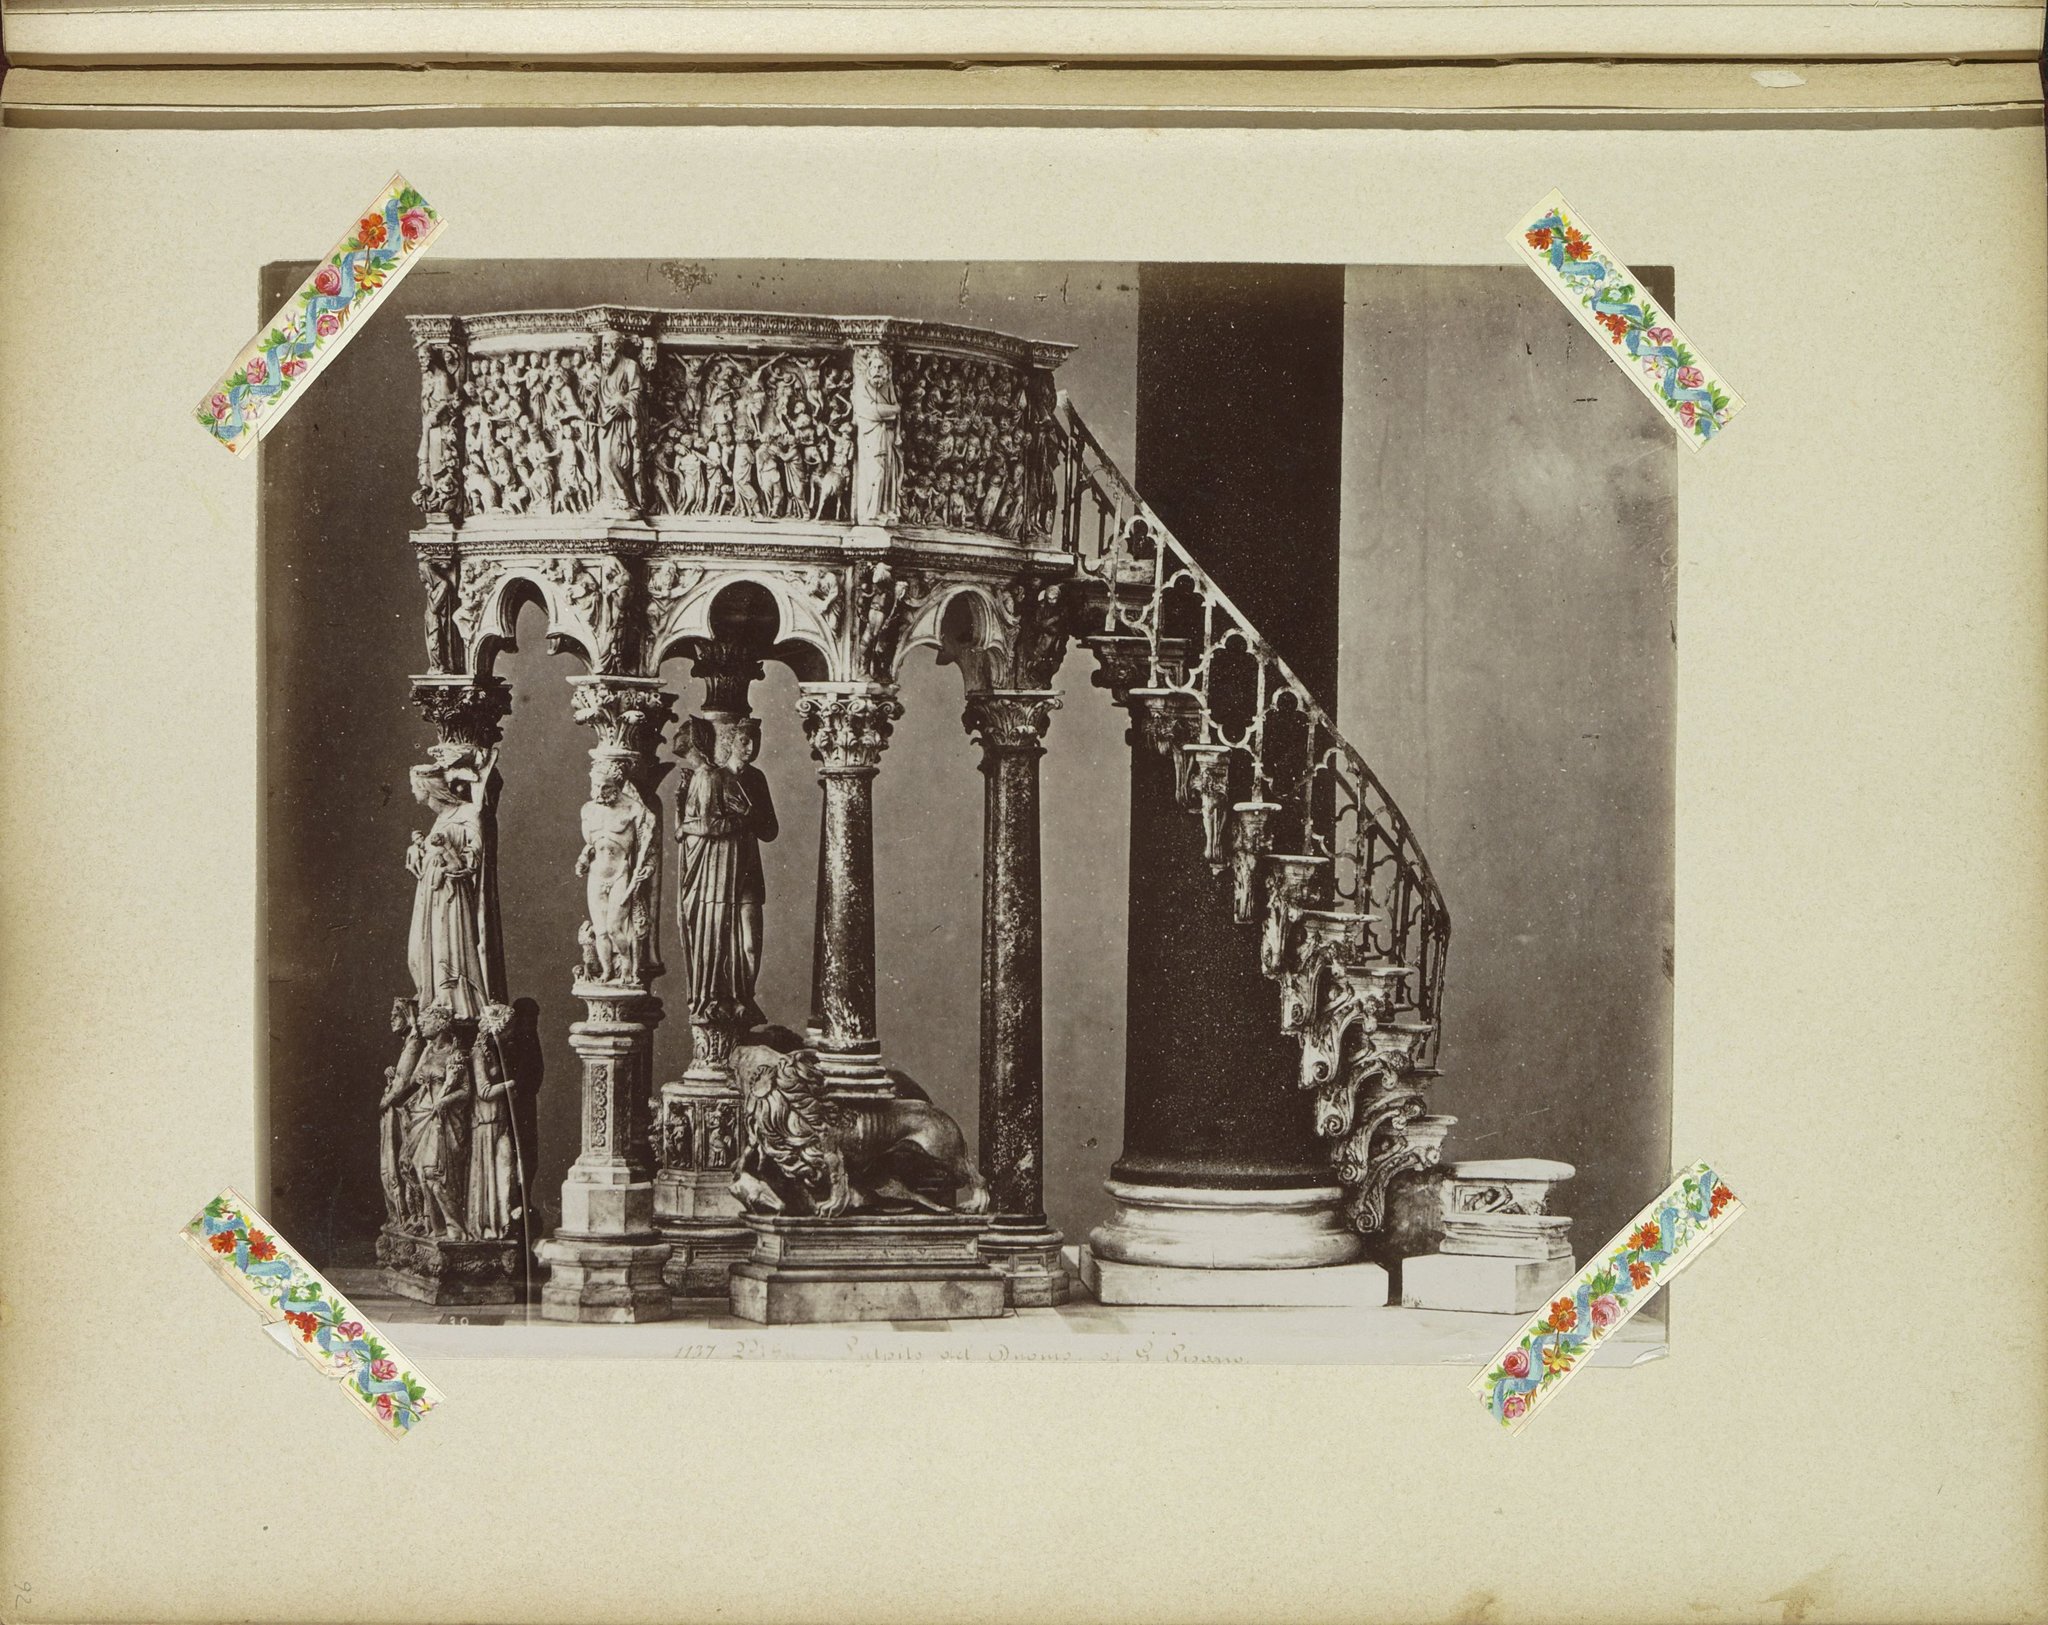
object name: photograph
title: Preekstoel (ambo) in de Dom van Pisa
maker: Anonymous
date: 1860-1900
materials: photographic support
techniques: albumen print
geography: pisa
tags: pulpit, ambo, chancel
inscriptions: number: ‘30’, number: ‘1137’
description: Onderdeel van Fotoalbum met opnames van bezienswaardigheden in Italiaanse steden en van kunstwerken.